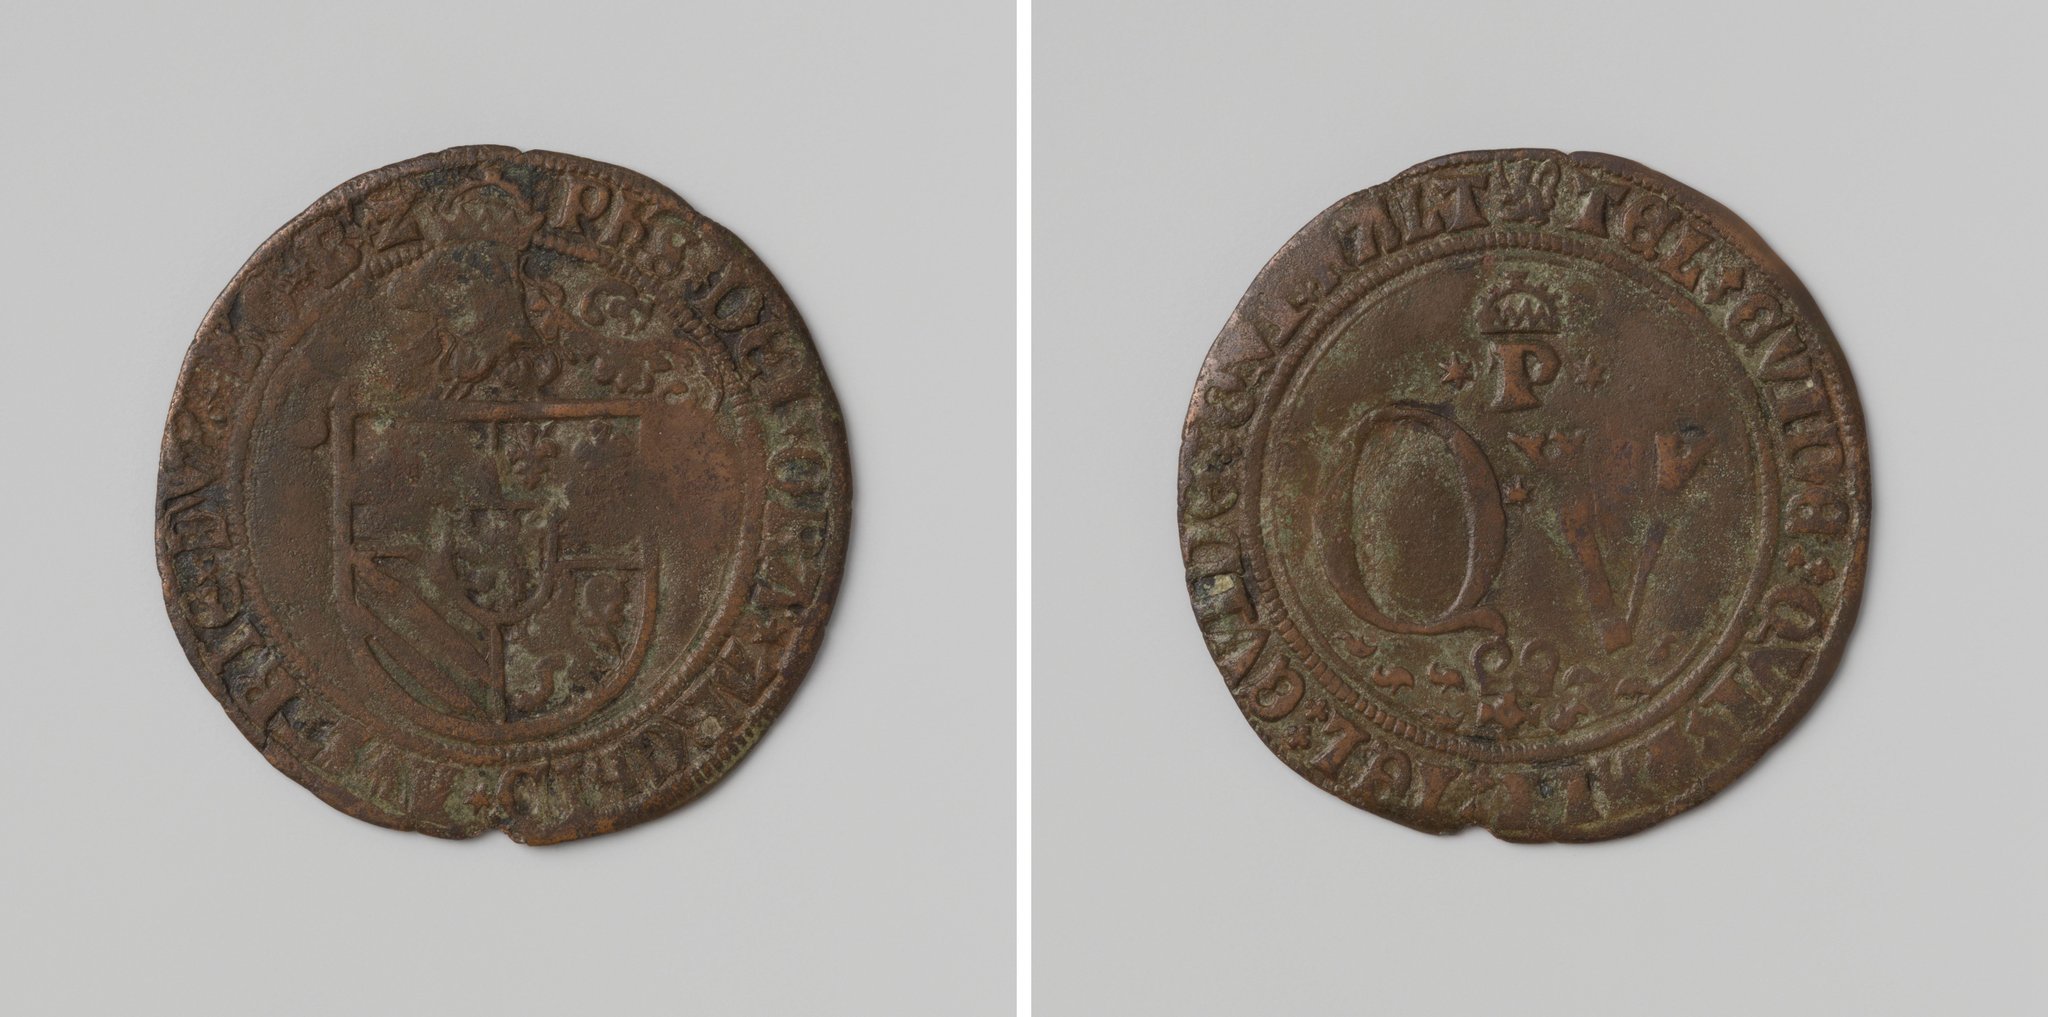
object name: jeton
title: Filips de Schone, hertog van Bourgondie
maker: Anonymous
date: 1496-1508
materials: copper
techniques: striking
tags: bruges, filips de schone (hertog van bourgondië)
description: Koperen penning. Voorzijde: wapenschild onder gekroonde helm binnen omschrift. Keerzijde: bekroonde letter P tussen twee sterretjes, monogram van letters Q en V, gescheiden door sterretje en vuurslag, waar vonken uit schieten binnen omschrift